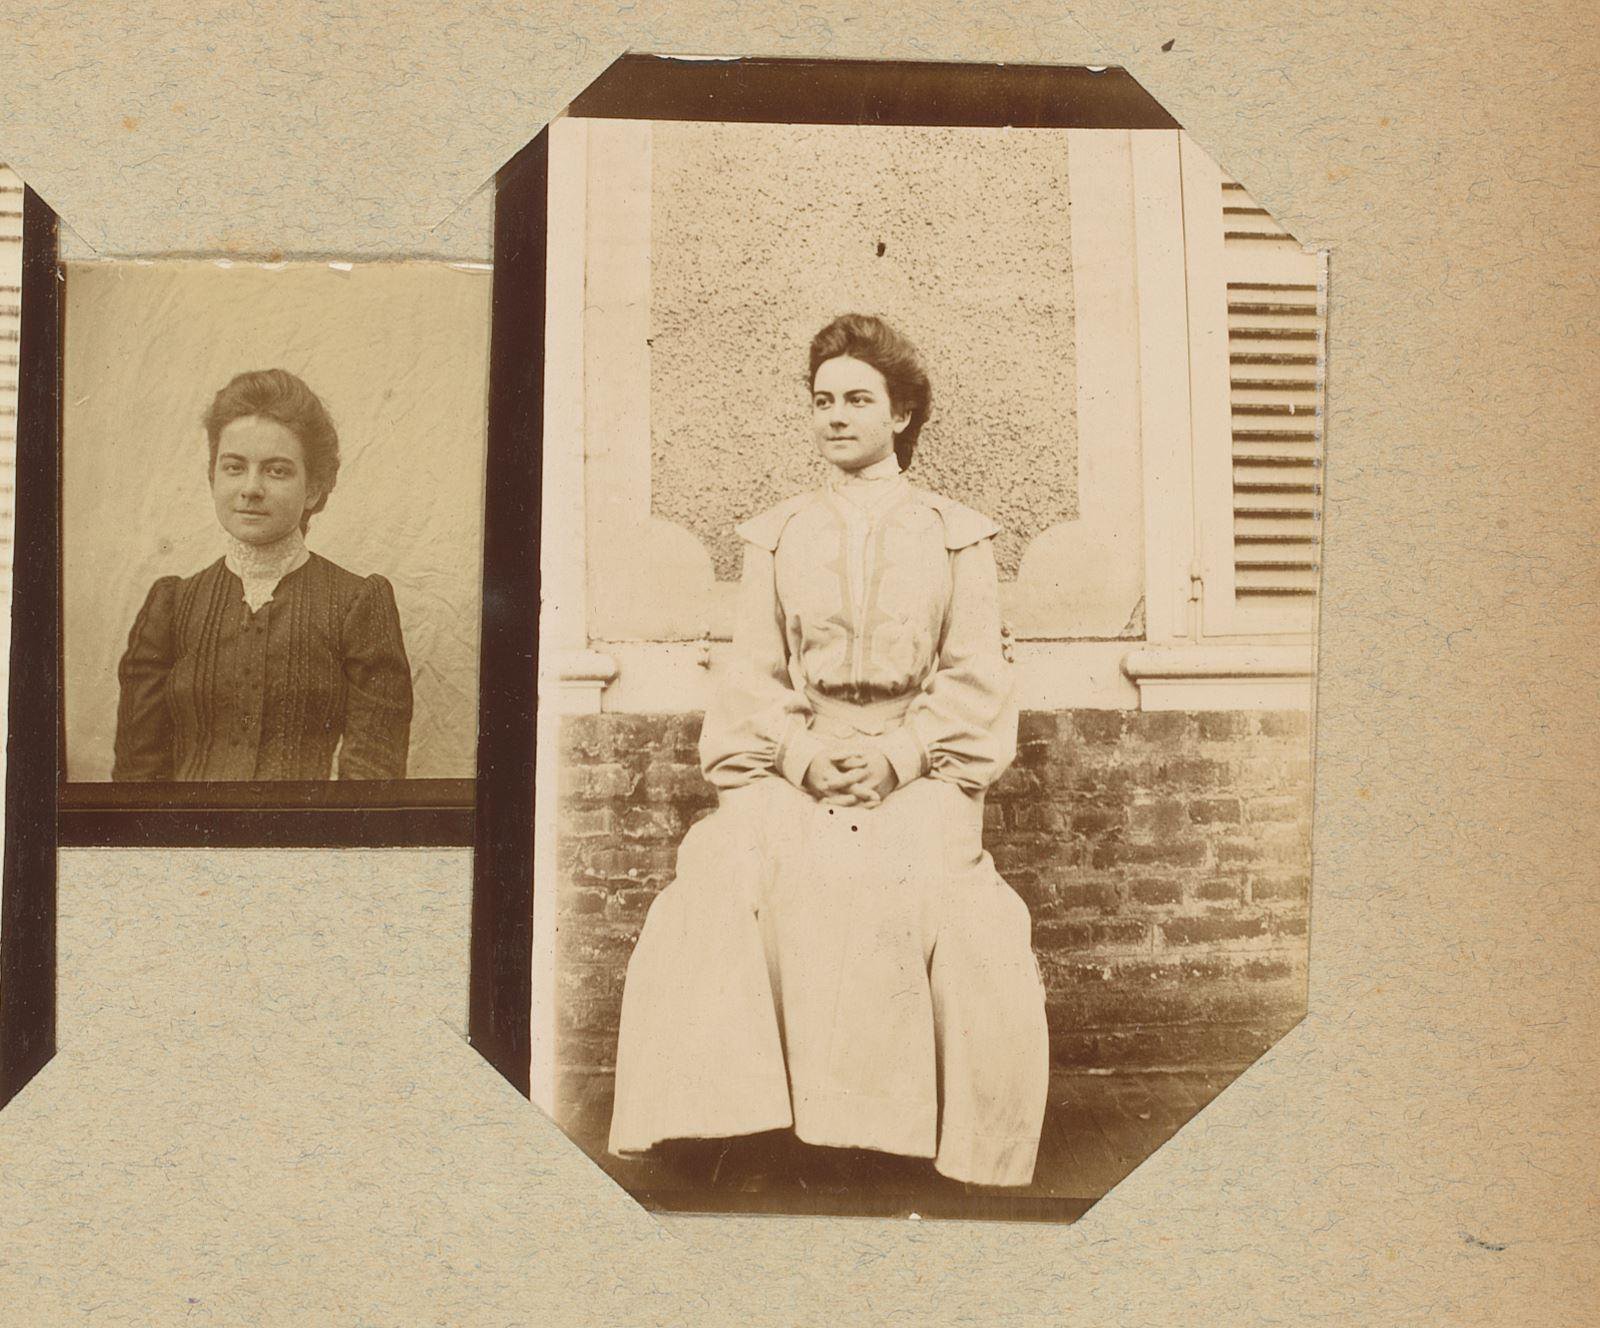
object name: album leaf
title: Portret van een jonge vrouw in jurk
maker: Anonymous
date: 1897-1900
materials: paper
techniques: gelatin silver print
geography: france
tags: adolescent, young woman, maiden, historical persons, france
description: Over de foto is een ander negatief afgedrukt van een voorstelling van bomen.